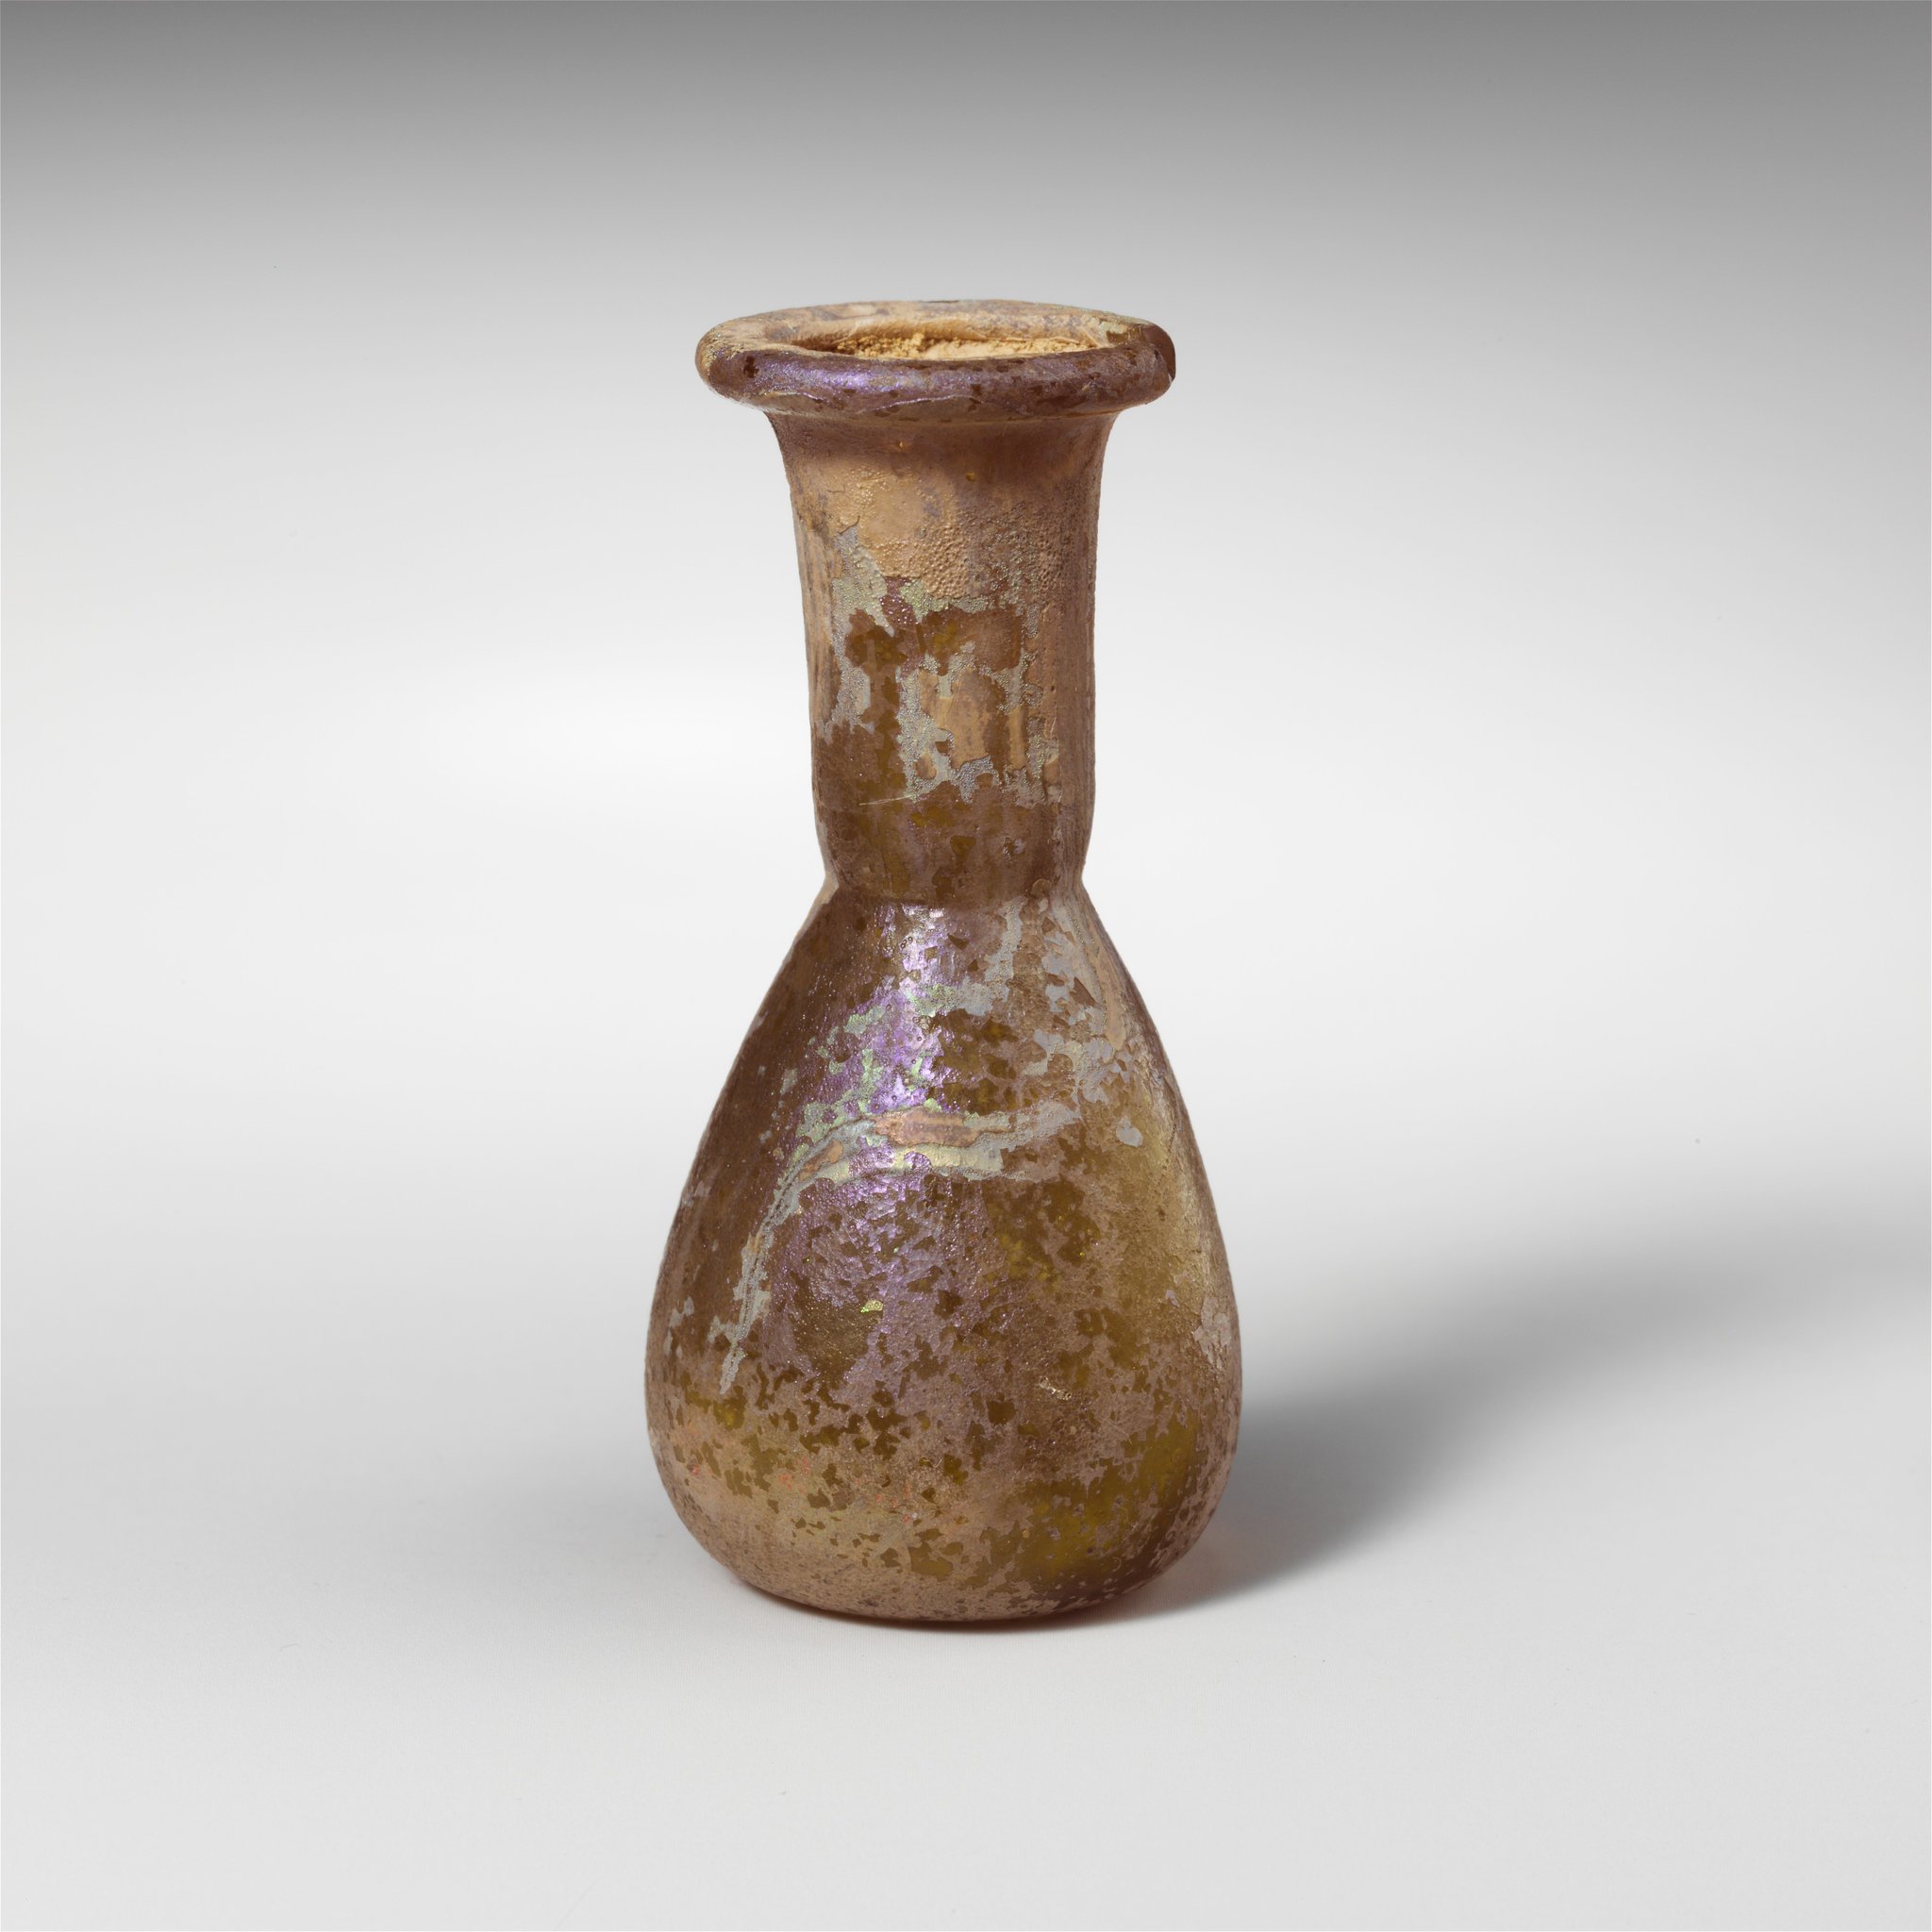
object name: perfume bottle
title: Glass perfume bottle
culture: roman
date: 1-100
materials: glass